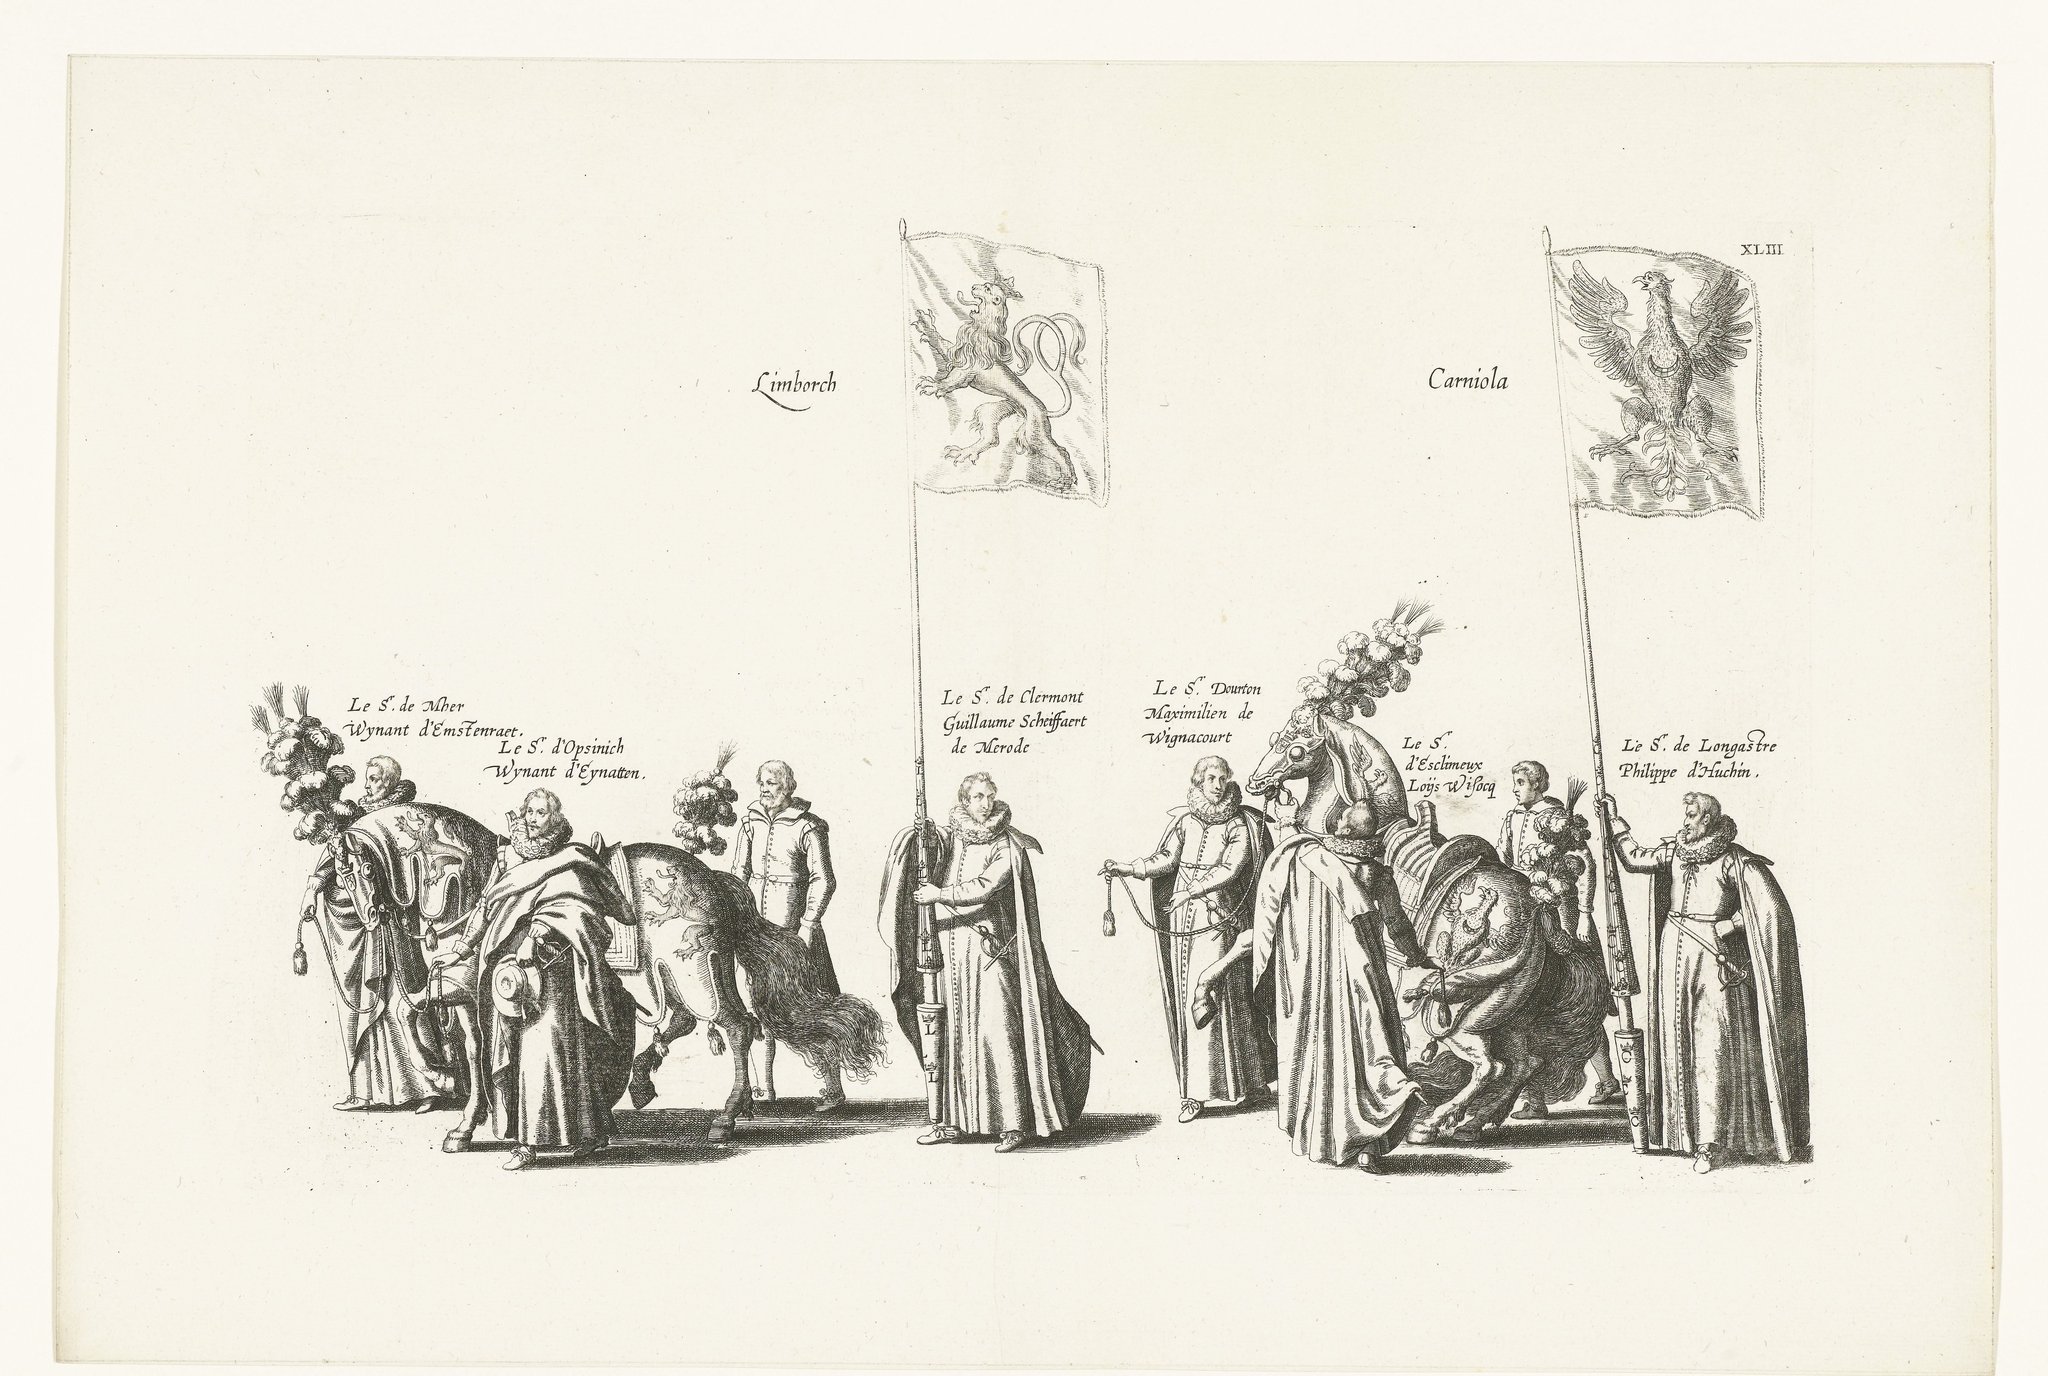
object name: print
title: Pompa funebris optimi potentissimiq. principis Alberti pii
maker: cornelis galle (i)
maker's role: print maker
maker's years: 1576-1650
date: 1623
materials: paper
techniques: etching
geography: southern netherlands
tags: albrecht aartshertog van oostenrijk, cortege, funeral procession, brussels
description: Deelnemers in de begrafenisstoet met de vaandels van Limborch en Carniola. Plaat XLIII in de serie van de begrafenis van aartshertog Albrecht van Oostenrijk te Brussel op 12 maart 1622.